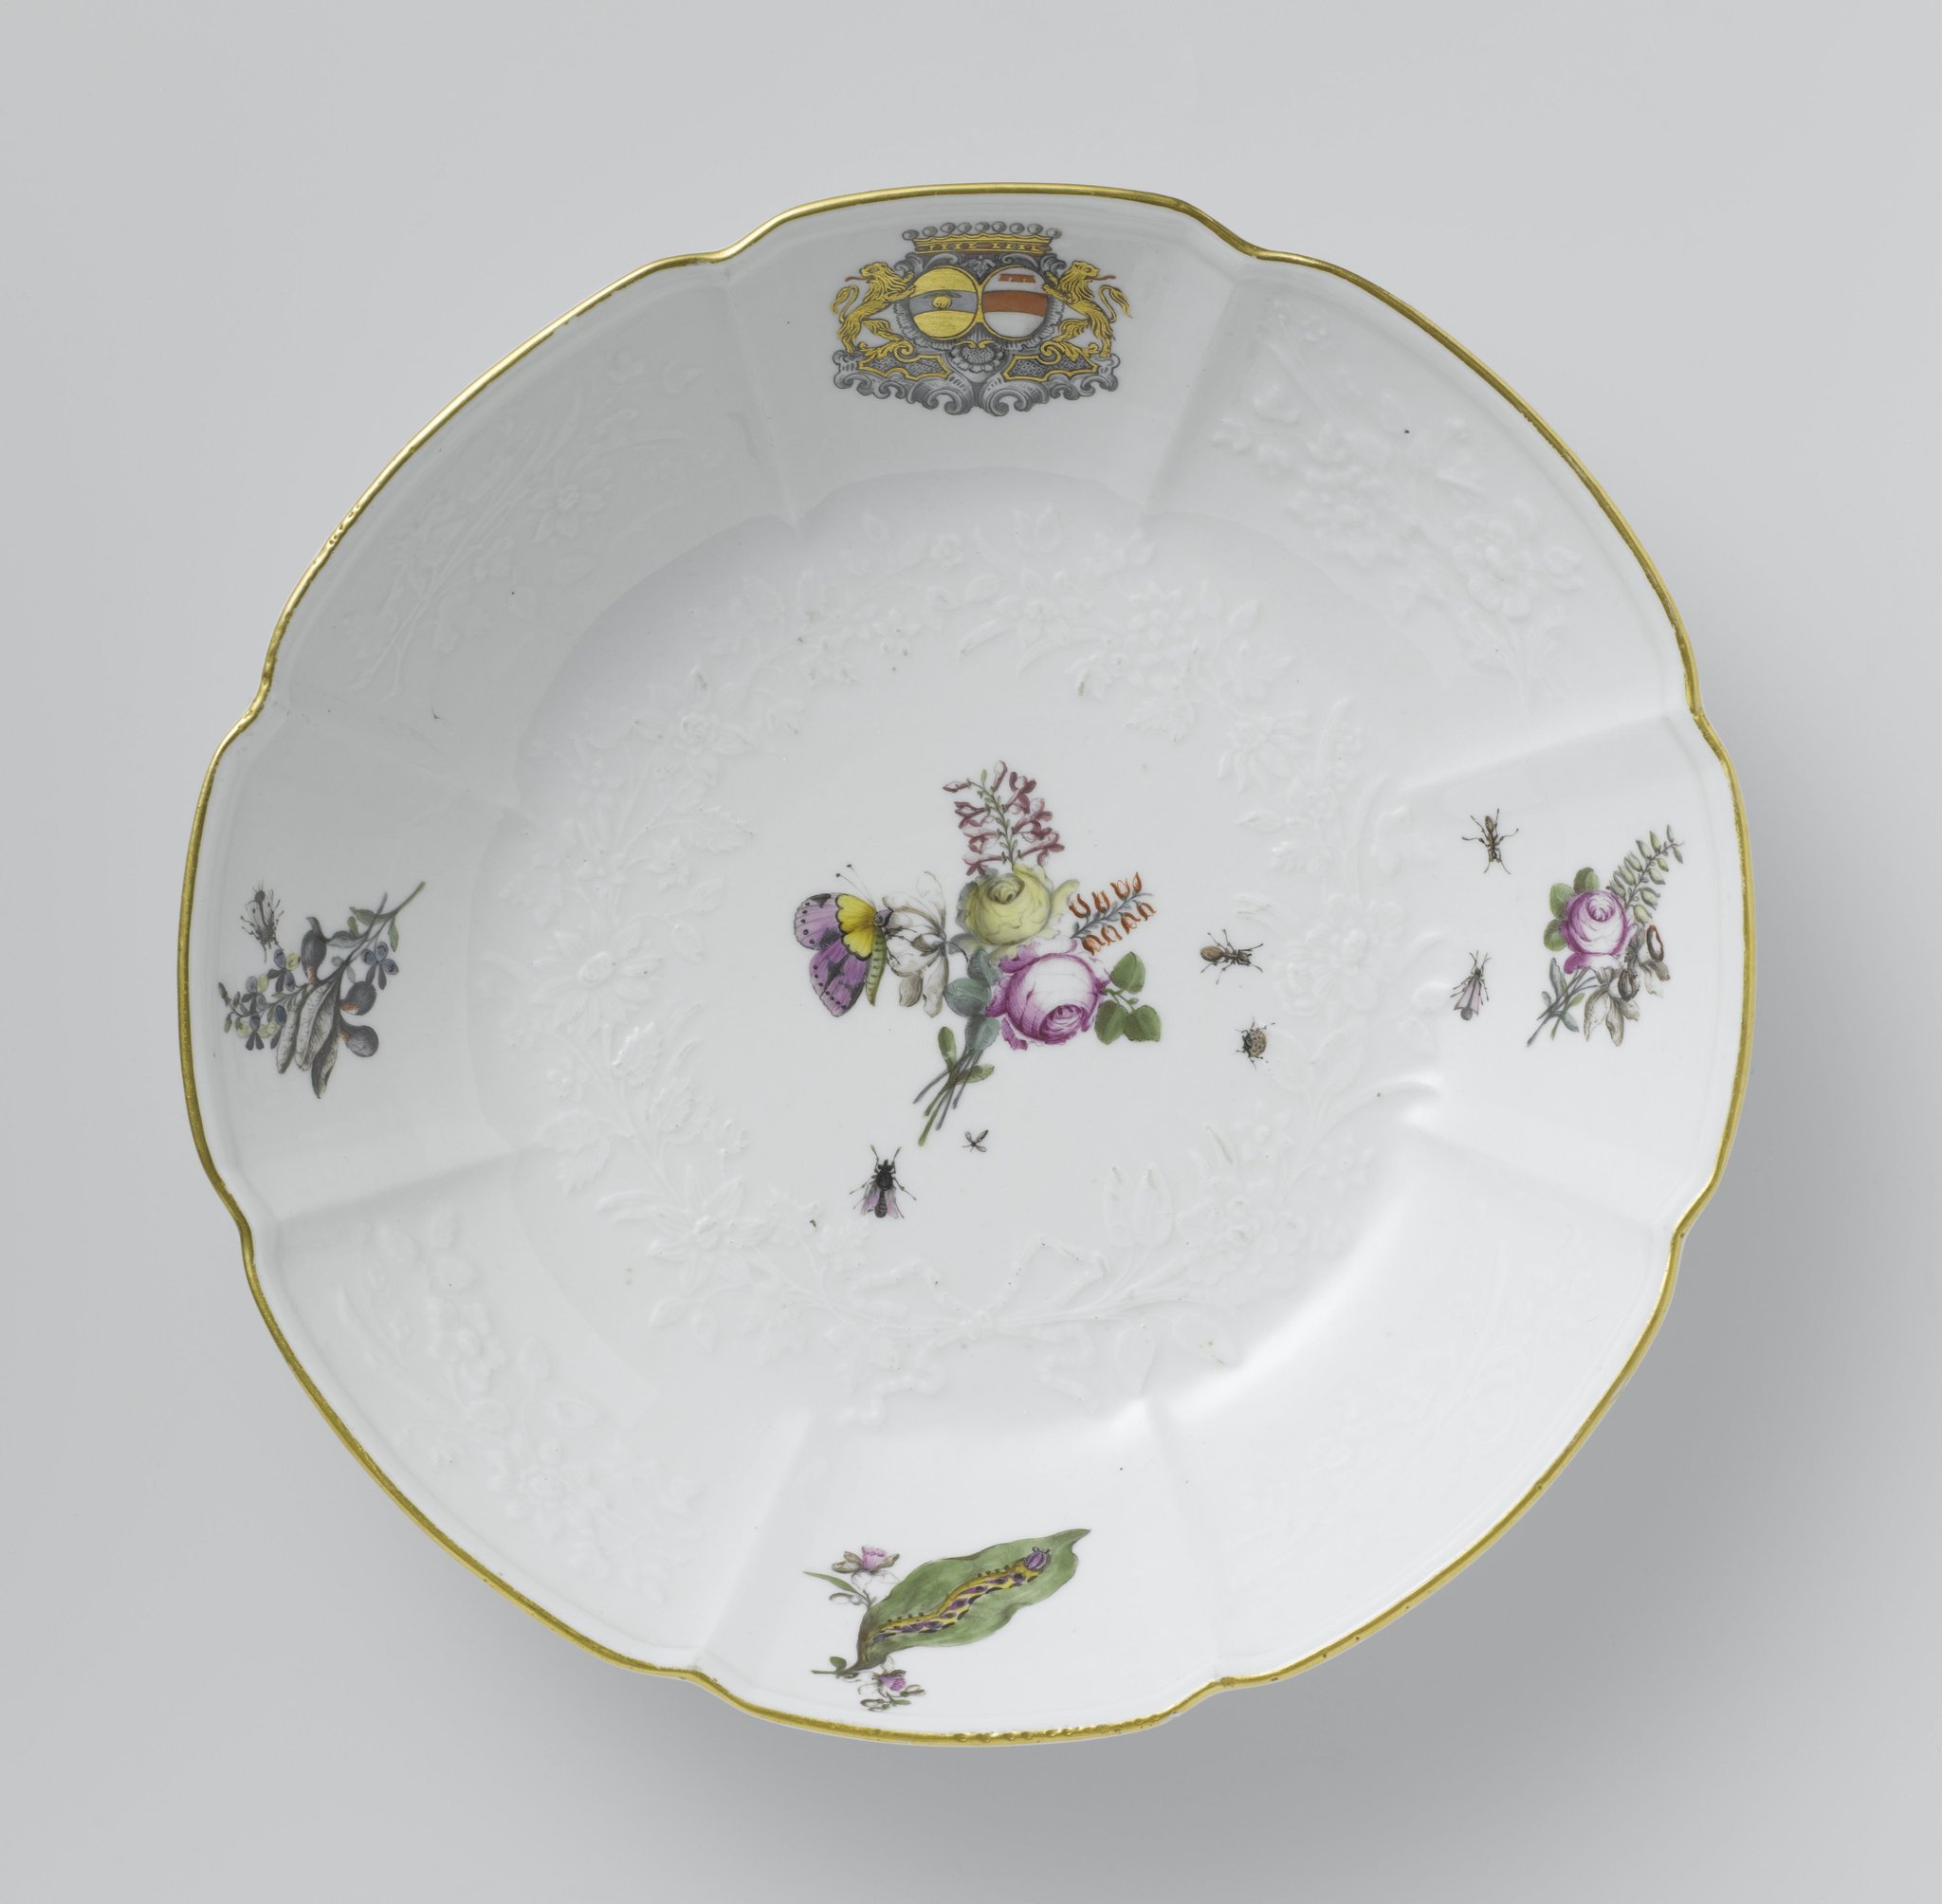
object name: plate dish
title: Plate with the alliance arms of Jean Paris de Montmartel and Marie Armande de Béthune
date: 1746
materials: porcelain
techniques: painted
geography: meissen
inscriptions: mold mark: ‘20’, mark: ‘\\\’, factory mark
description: Meissener Porzellan Manufaktur Meissen, c. 1746 hard-paste porcelain